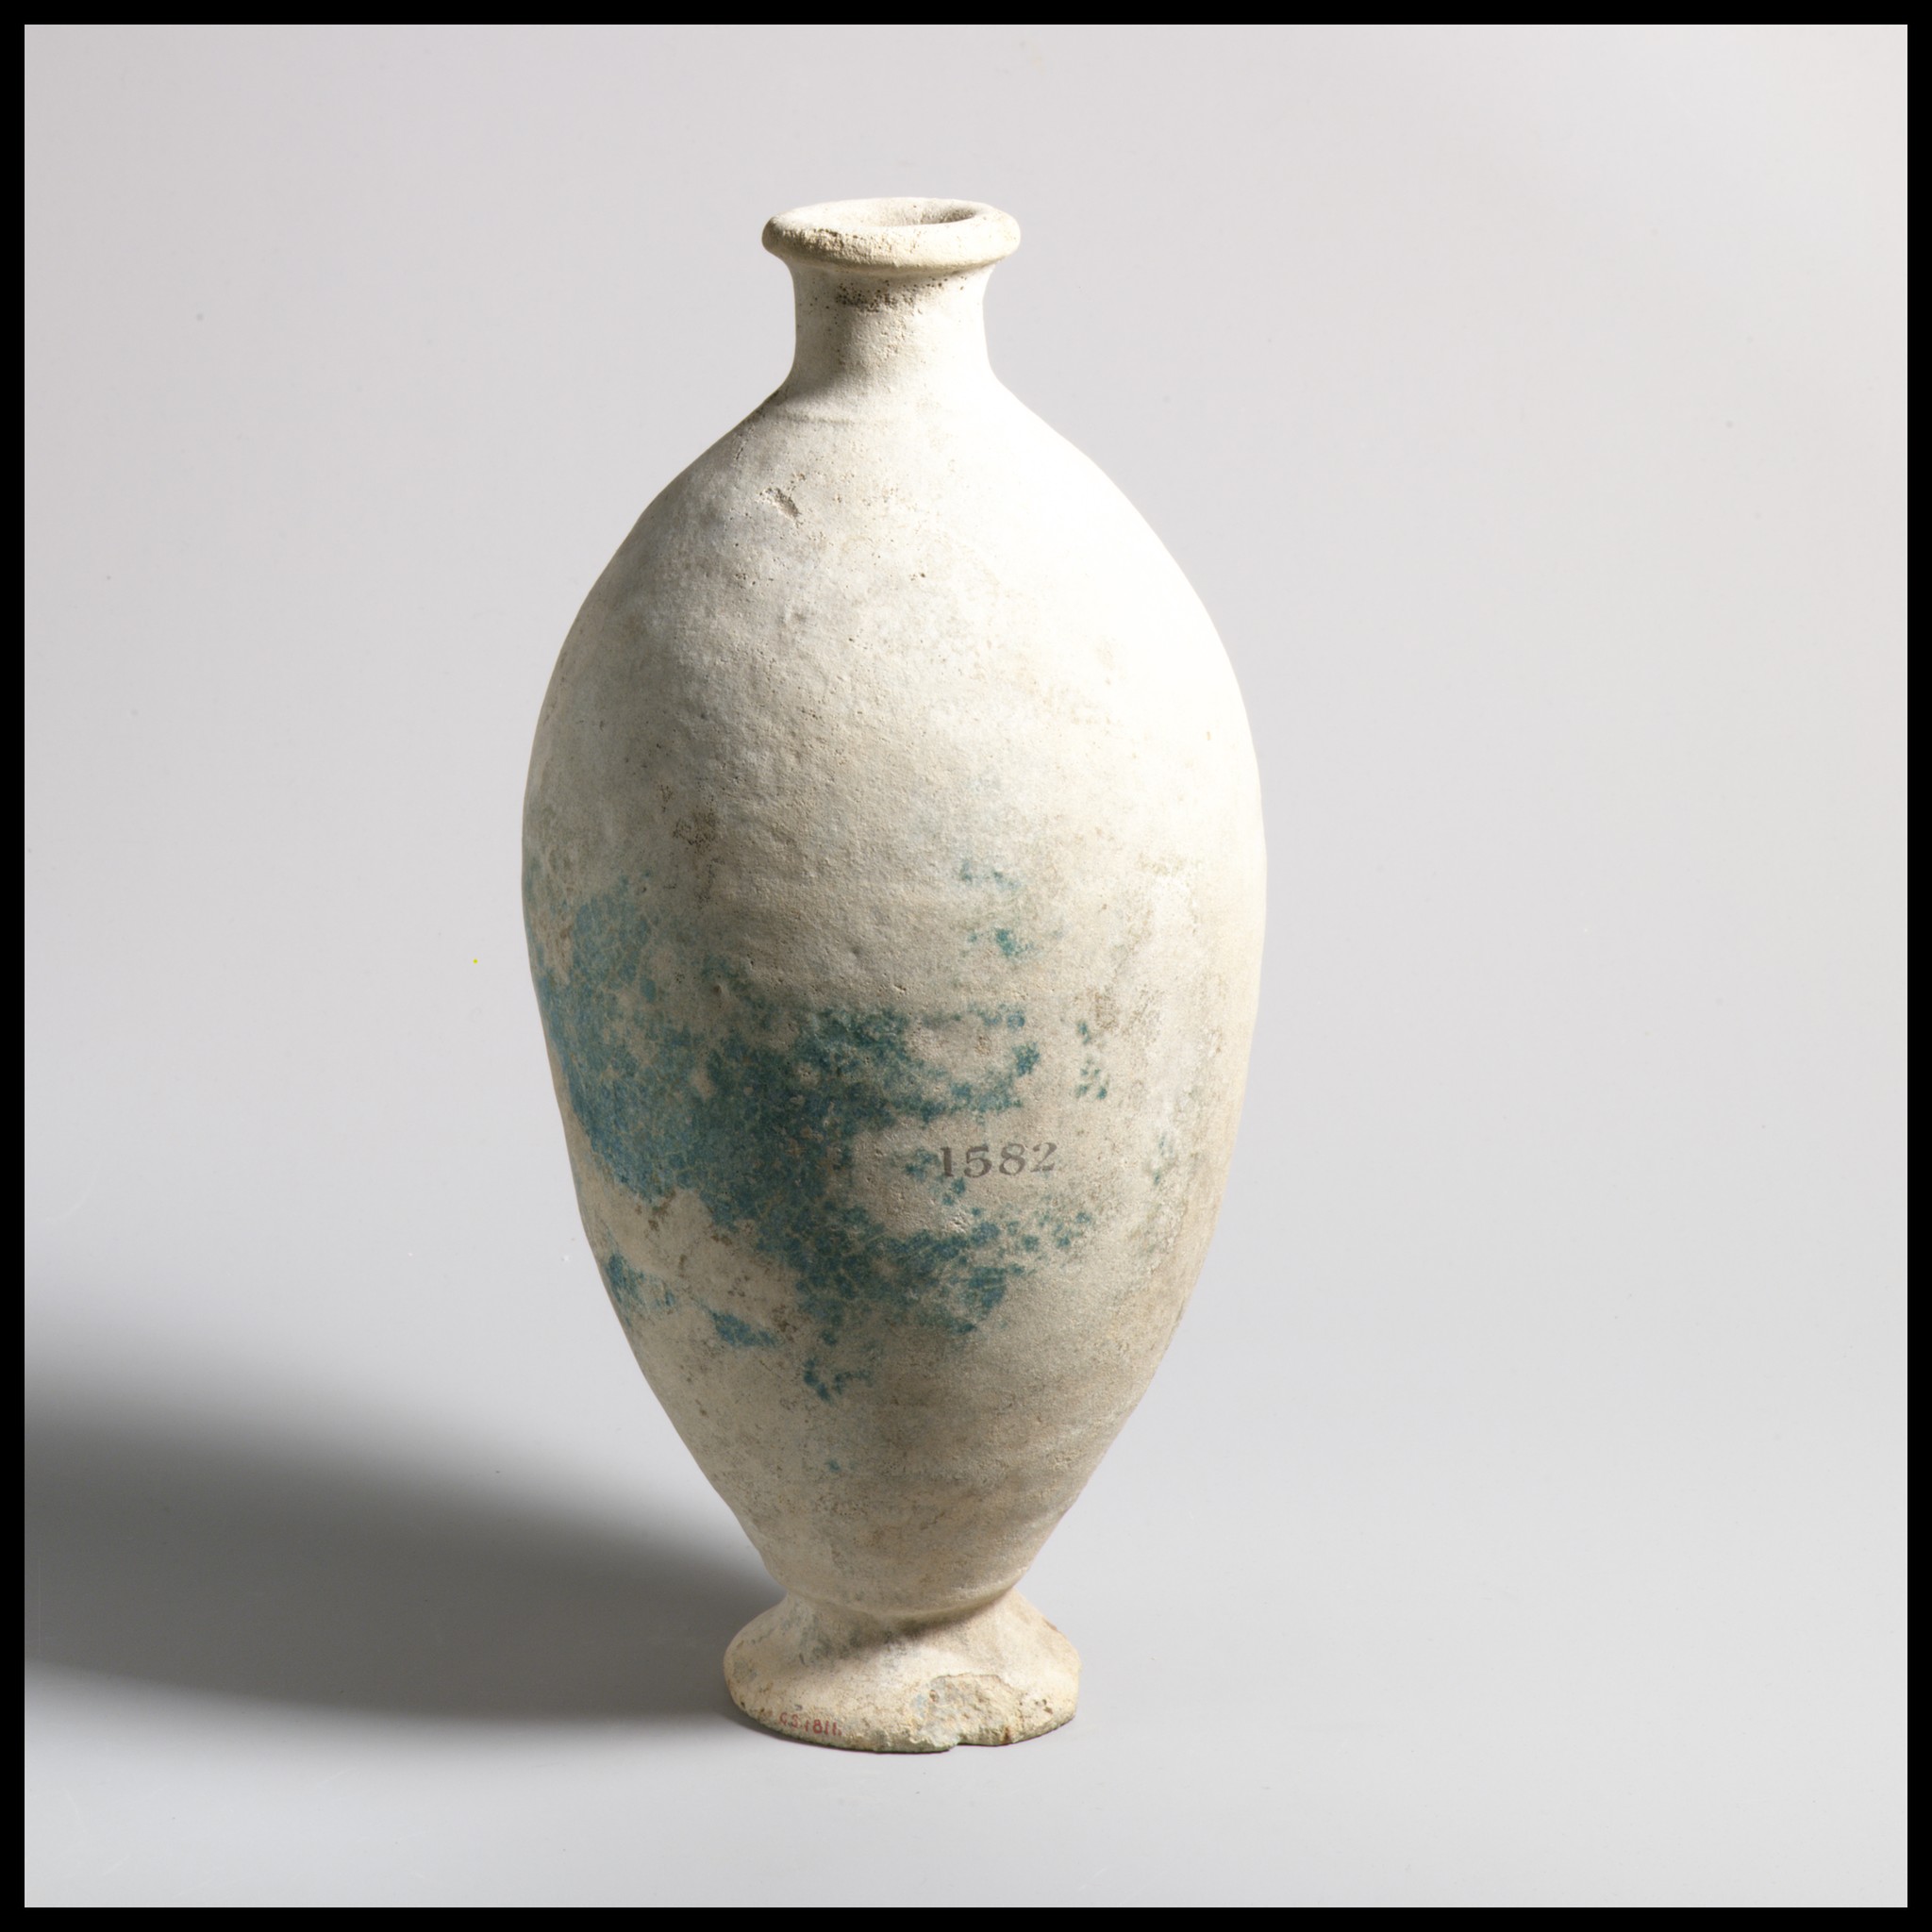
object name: bottle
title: Clay bottle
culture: cypriot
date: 1300-1101 BCE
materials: clay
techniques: glazing